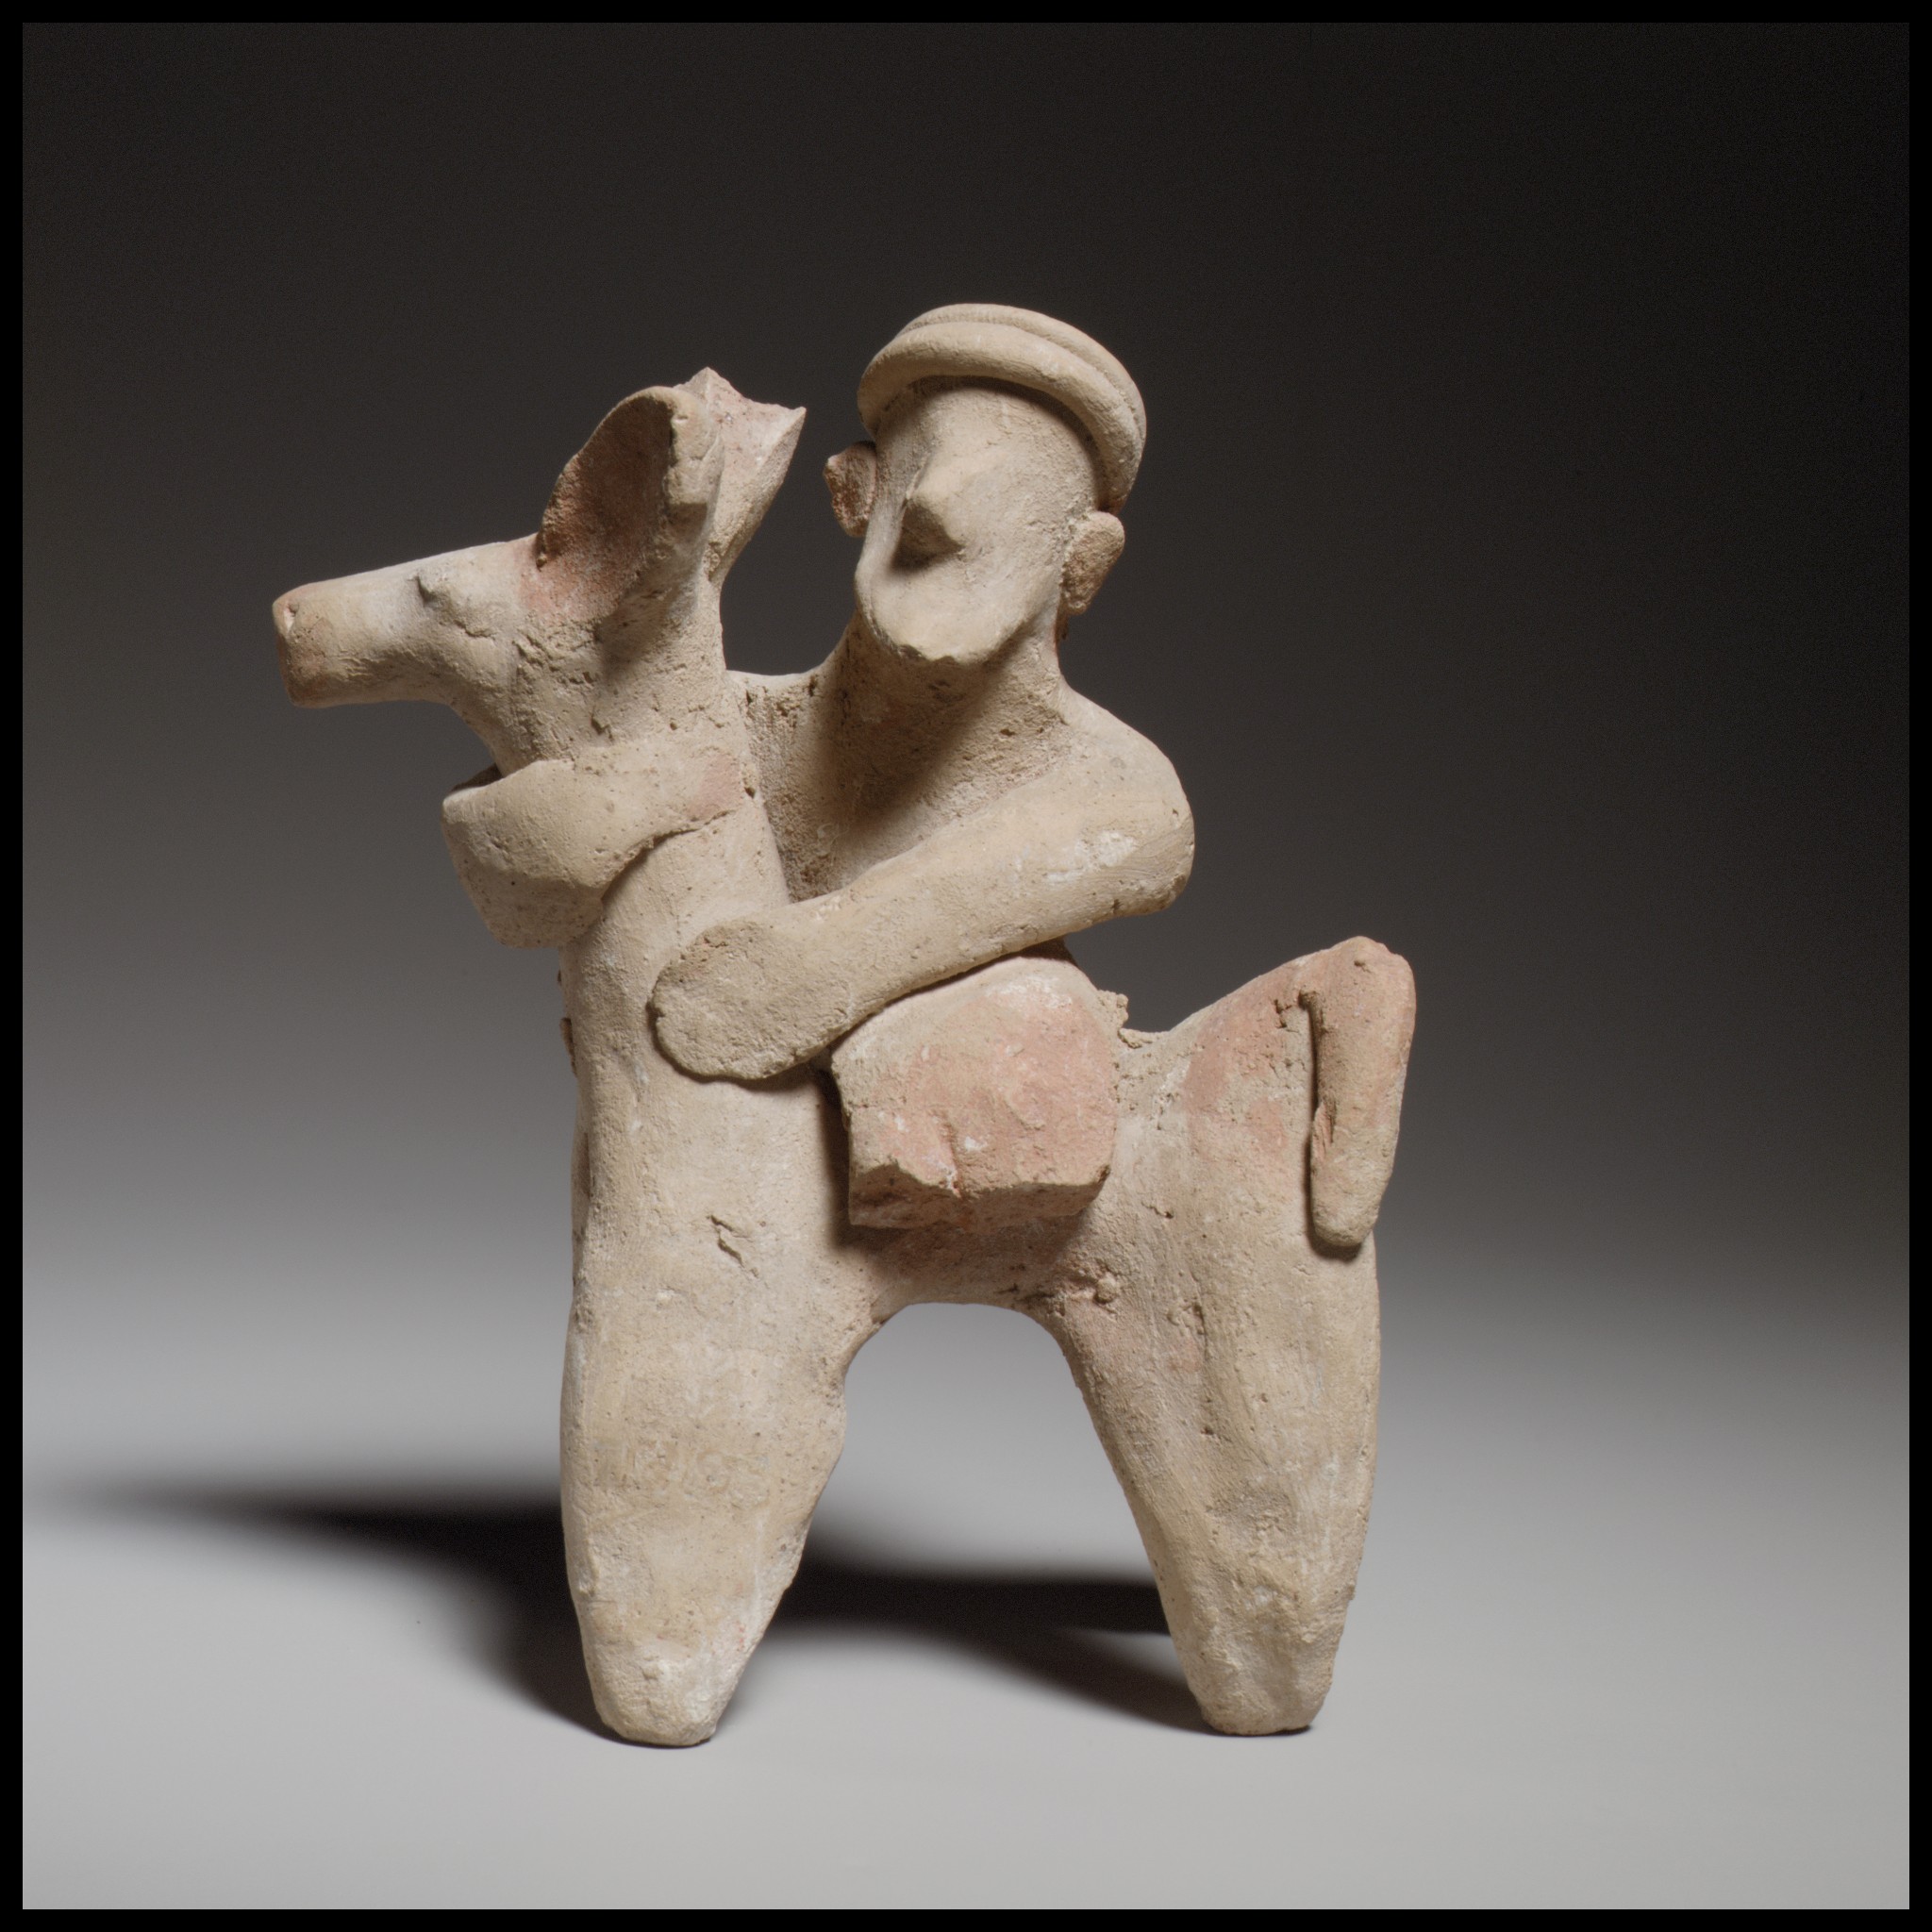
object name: statue of a man on an as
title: Terracotta statuette of a donkey and rider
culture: cypriot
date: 600-480 BCE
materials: terracotta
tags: men,donkeys